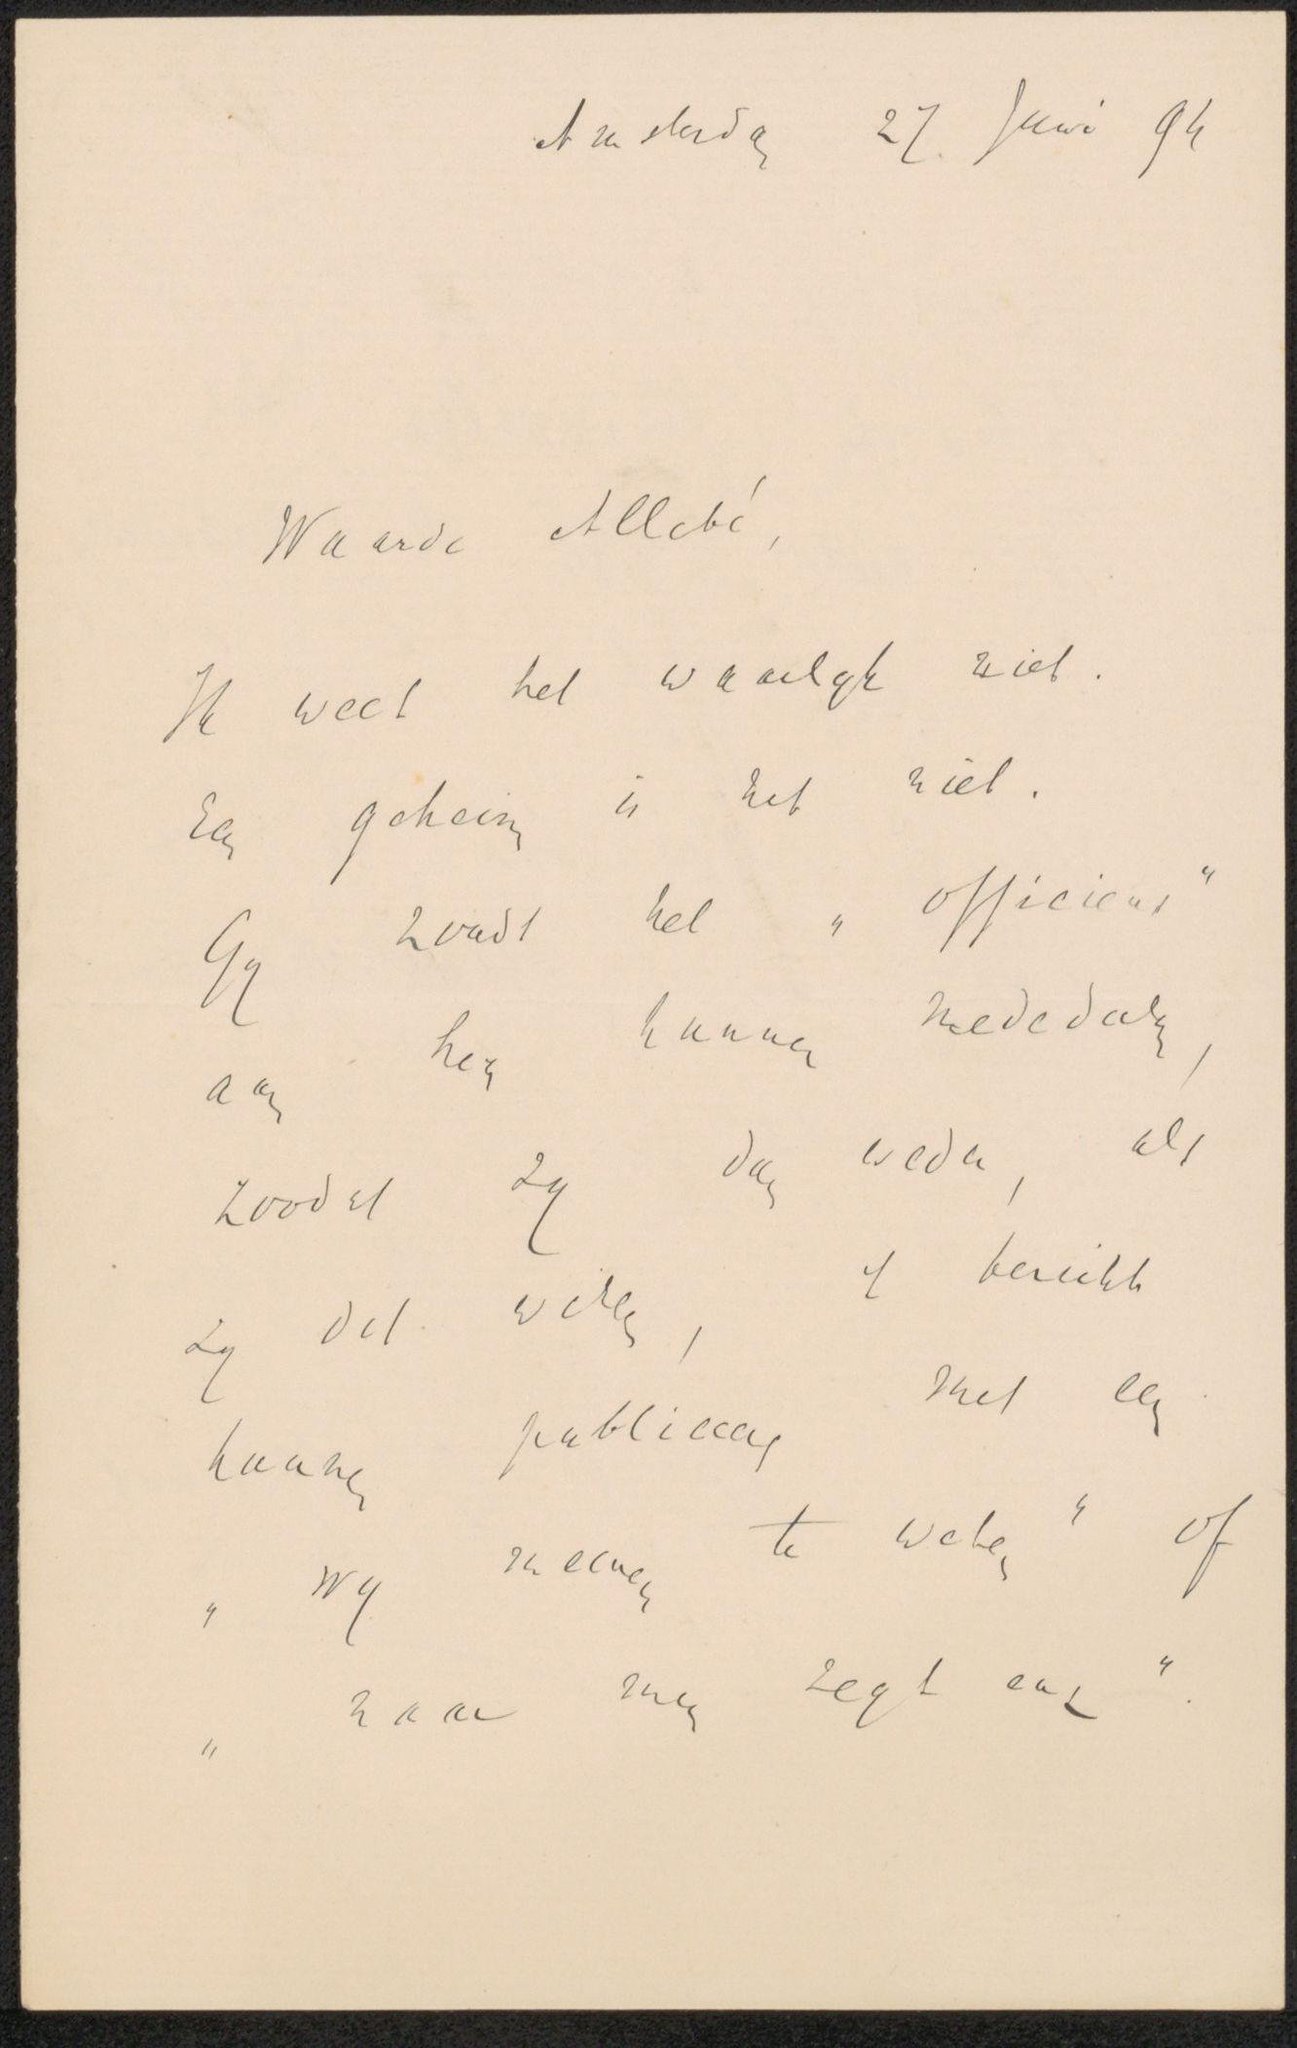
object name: letter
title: Brief aan August Allebé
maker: hendrick peter godfried quack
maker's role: econoom, geschiedschrijver, hoogleraar, jurist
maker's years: 1834-1917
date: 1894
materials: ink, paper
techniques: pen, writing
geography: amsterdam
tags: august allebé, amsterdam, politician, jérôme alexander sillem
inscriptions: watermark